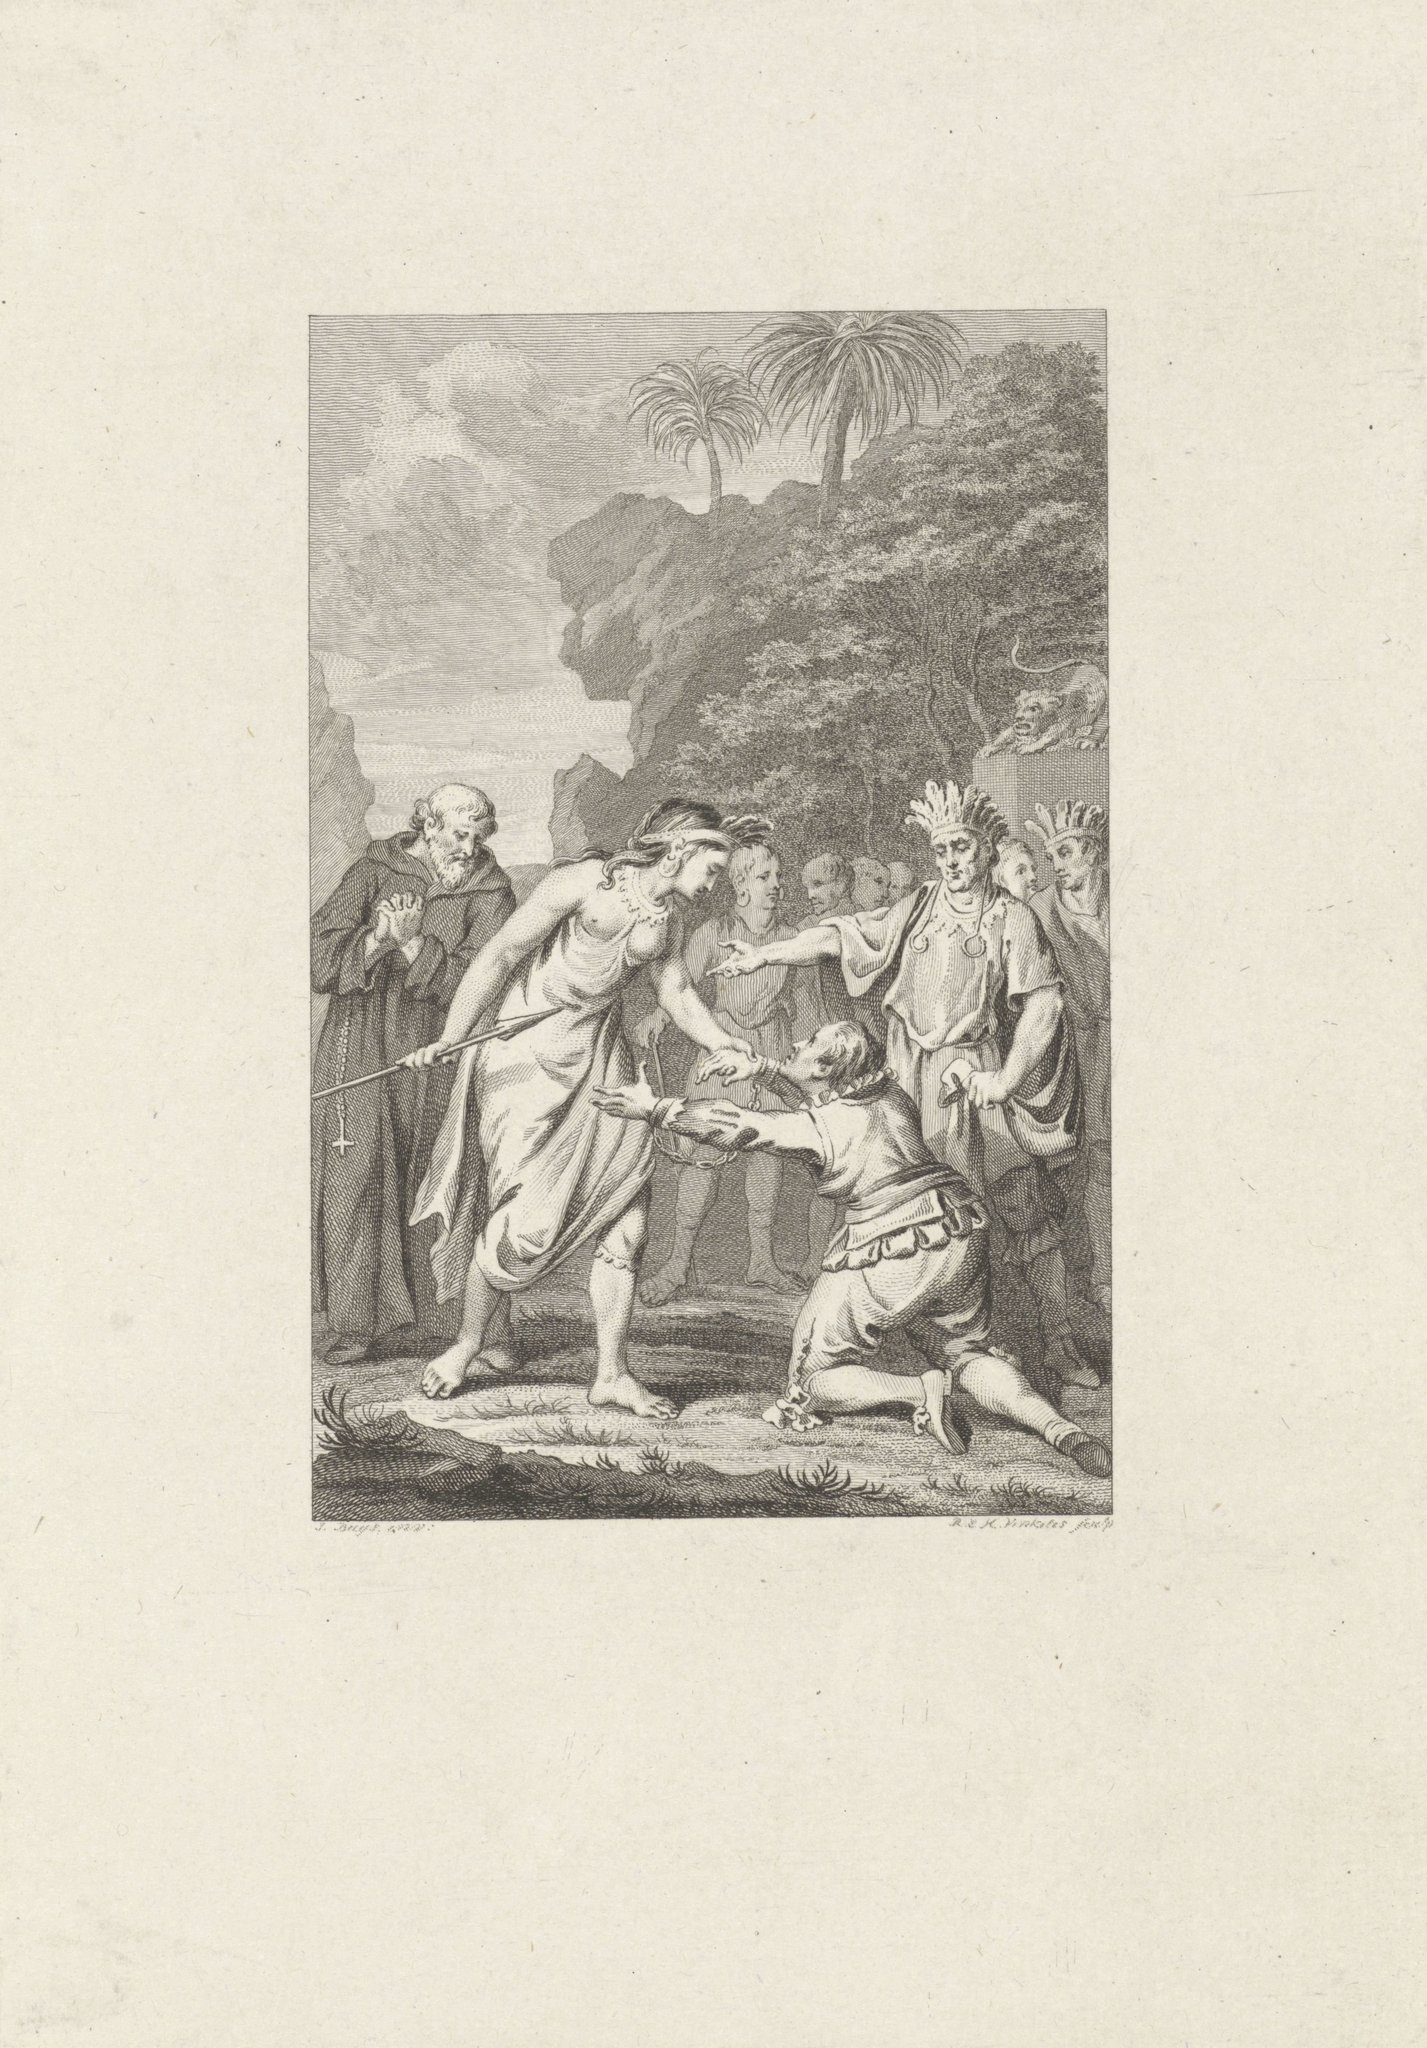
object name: print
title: Geboeide man knielt voor een vrouw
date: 1751-1816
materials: paper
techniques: engraving, etching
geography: amsterdam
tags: indigenous peoples of north america, monk(s), friar(s), kneeling figure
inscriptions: collector's mark: Lugt 240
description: Omringd door oorspronkelijke Amerikanen en een monnik knielt een geboeide man, mogelijk John Smith, voor een vrouw, mogelijk Pocahontas.